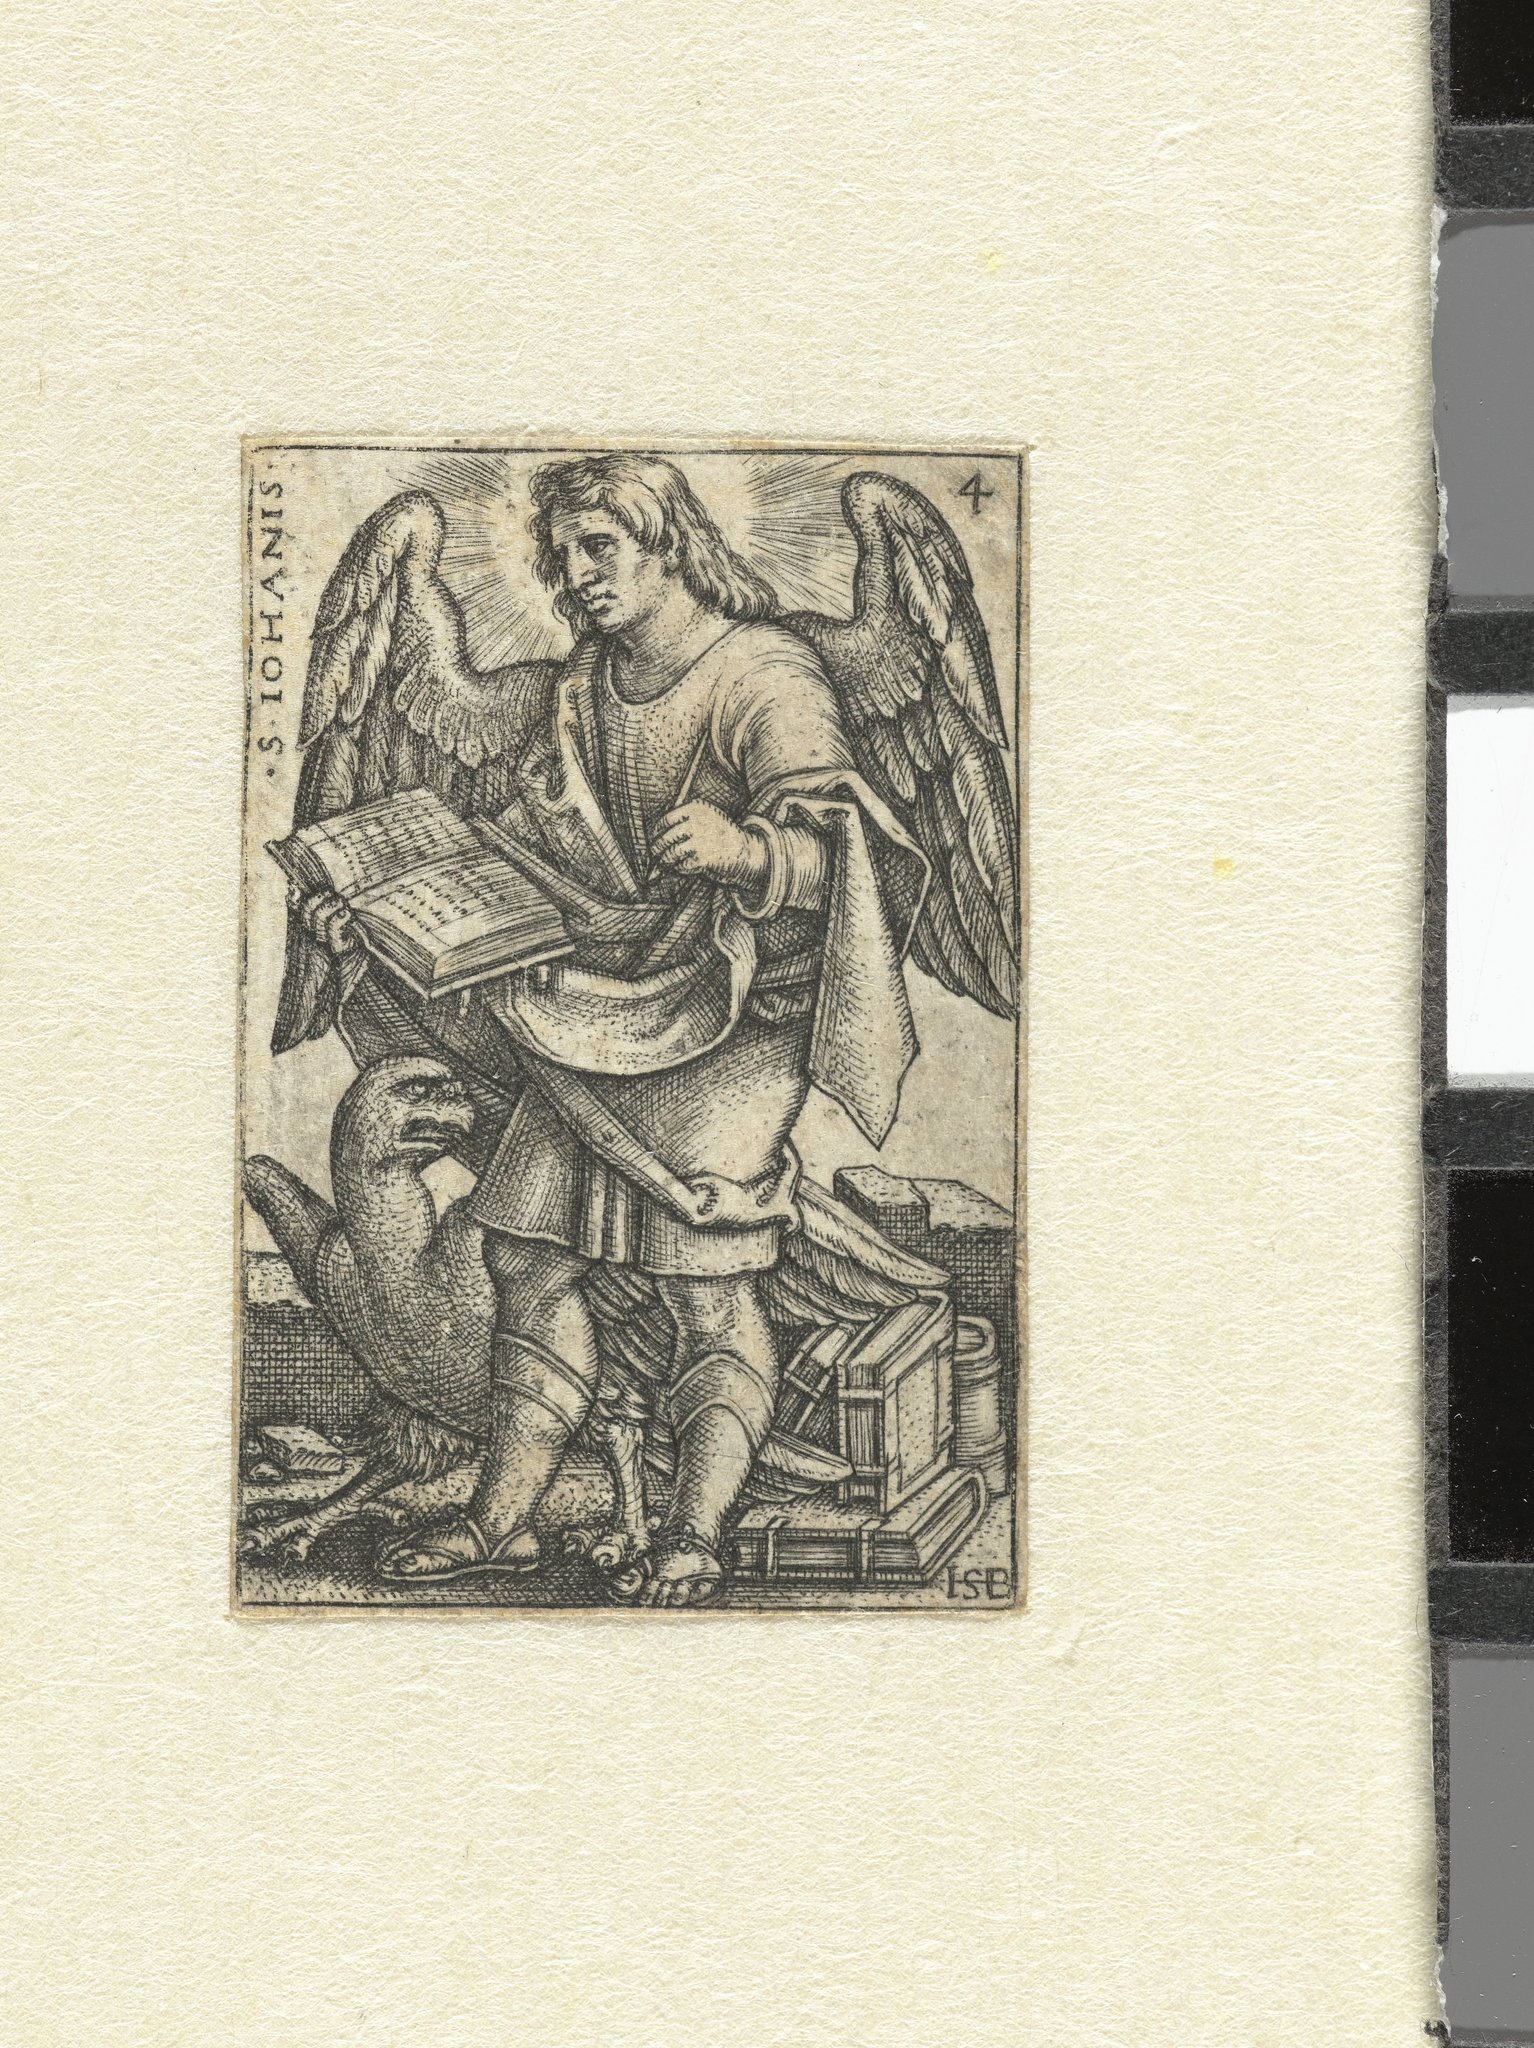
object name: print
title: Johannes de Evangelist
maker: hans sebald beham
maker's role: designer, draughtsman, print maker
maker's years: 1500-1550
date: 1541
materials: paper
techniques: engraving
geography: frankfurt am main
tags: the apostle john the evangelist; possible attributes: book, cauldron, chalice with snake, eagle, palm, scroll